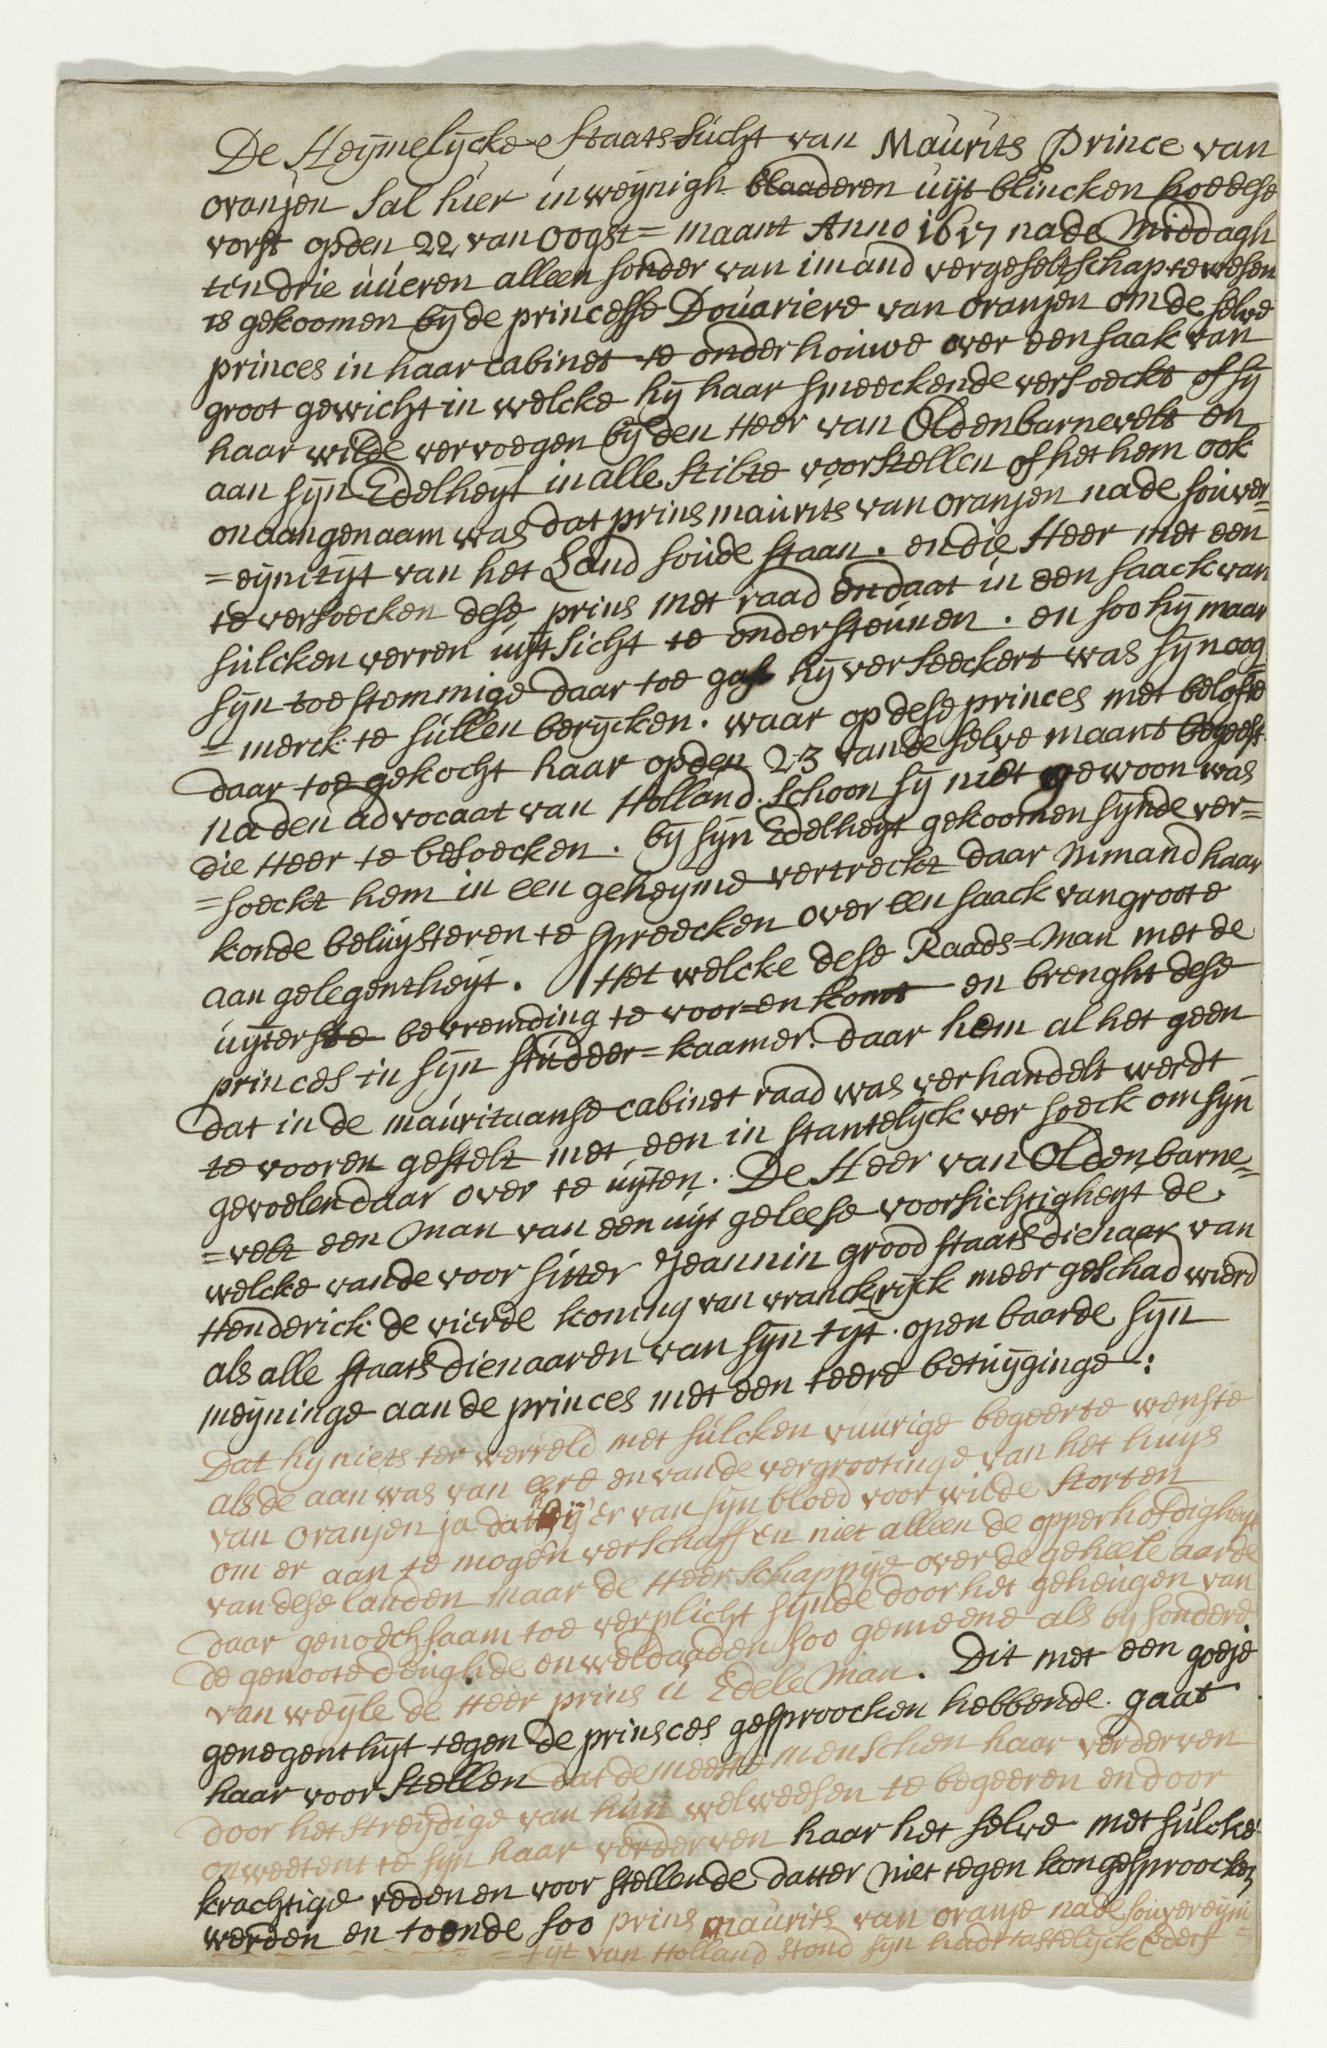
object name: manuscript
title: Toelichting op de spotprent van de Regtspleging van Oldenbarnevelt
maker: Anonymous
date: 1710-1720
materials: paper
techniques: pen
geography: netherlands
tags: the hague, johan van oldenbarnevelt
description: Twee dubbelgevouwen bladen met een geschreven toelichting op de voorstelling van de tekening van de Regtspleging van Oldenbarnevelt. Behorende bij serie aquarellen in boek.